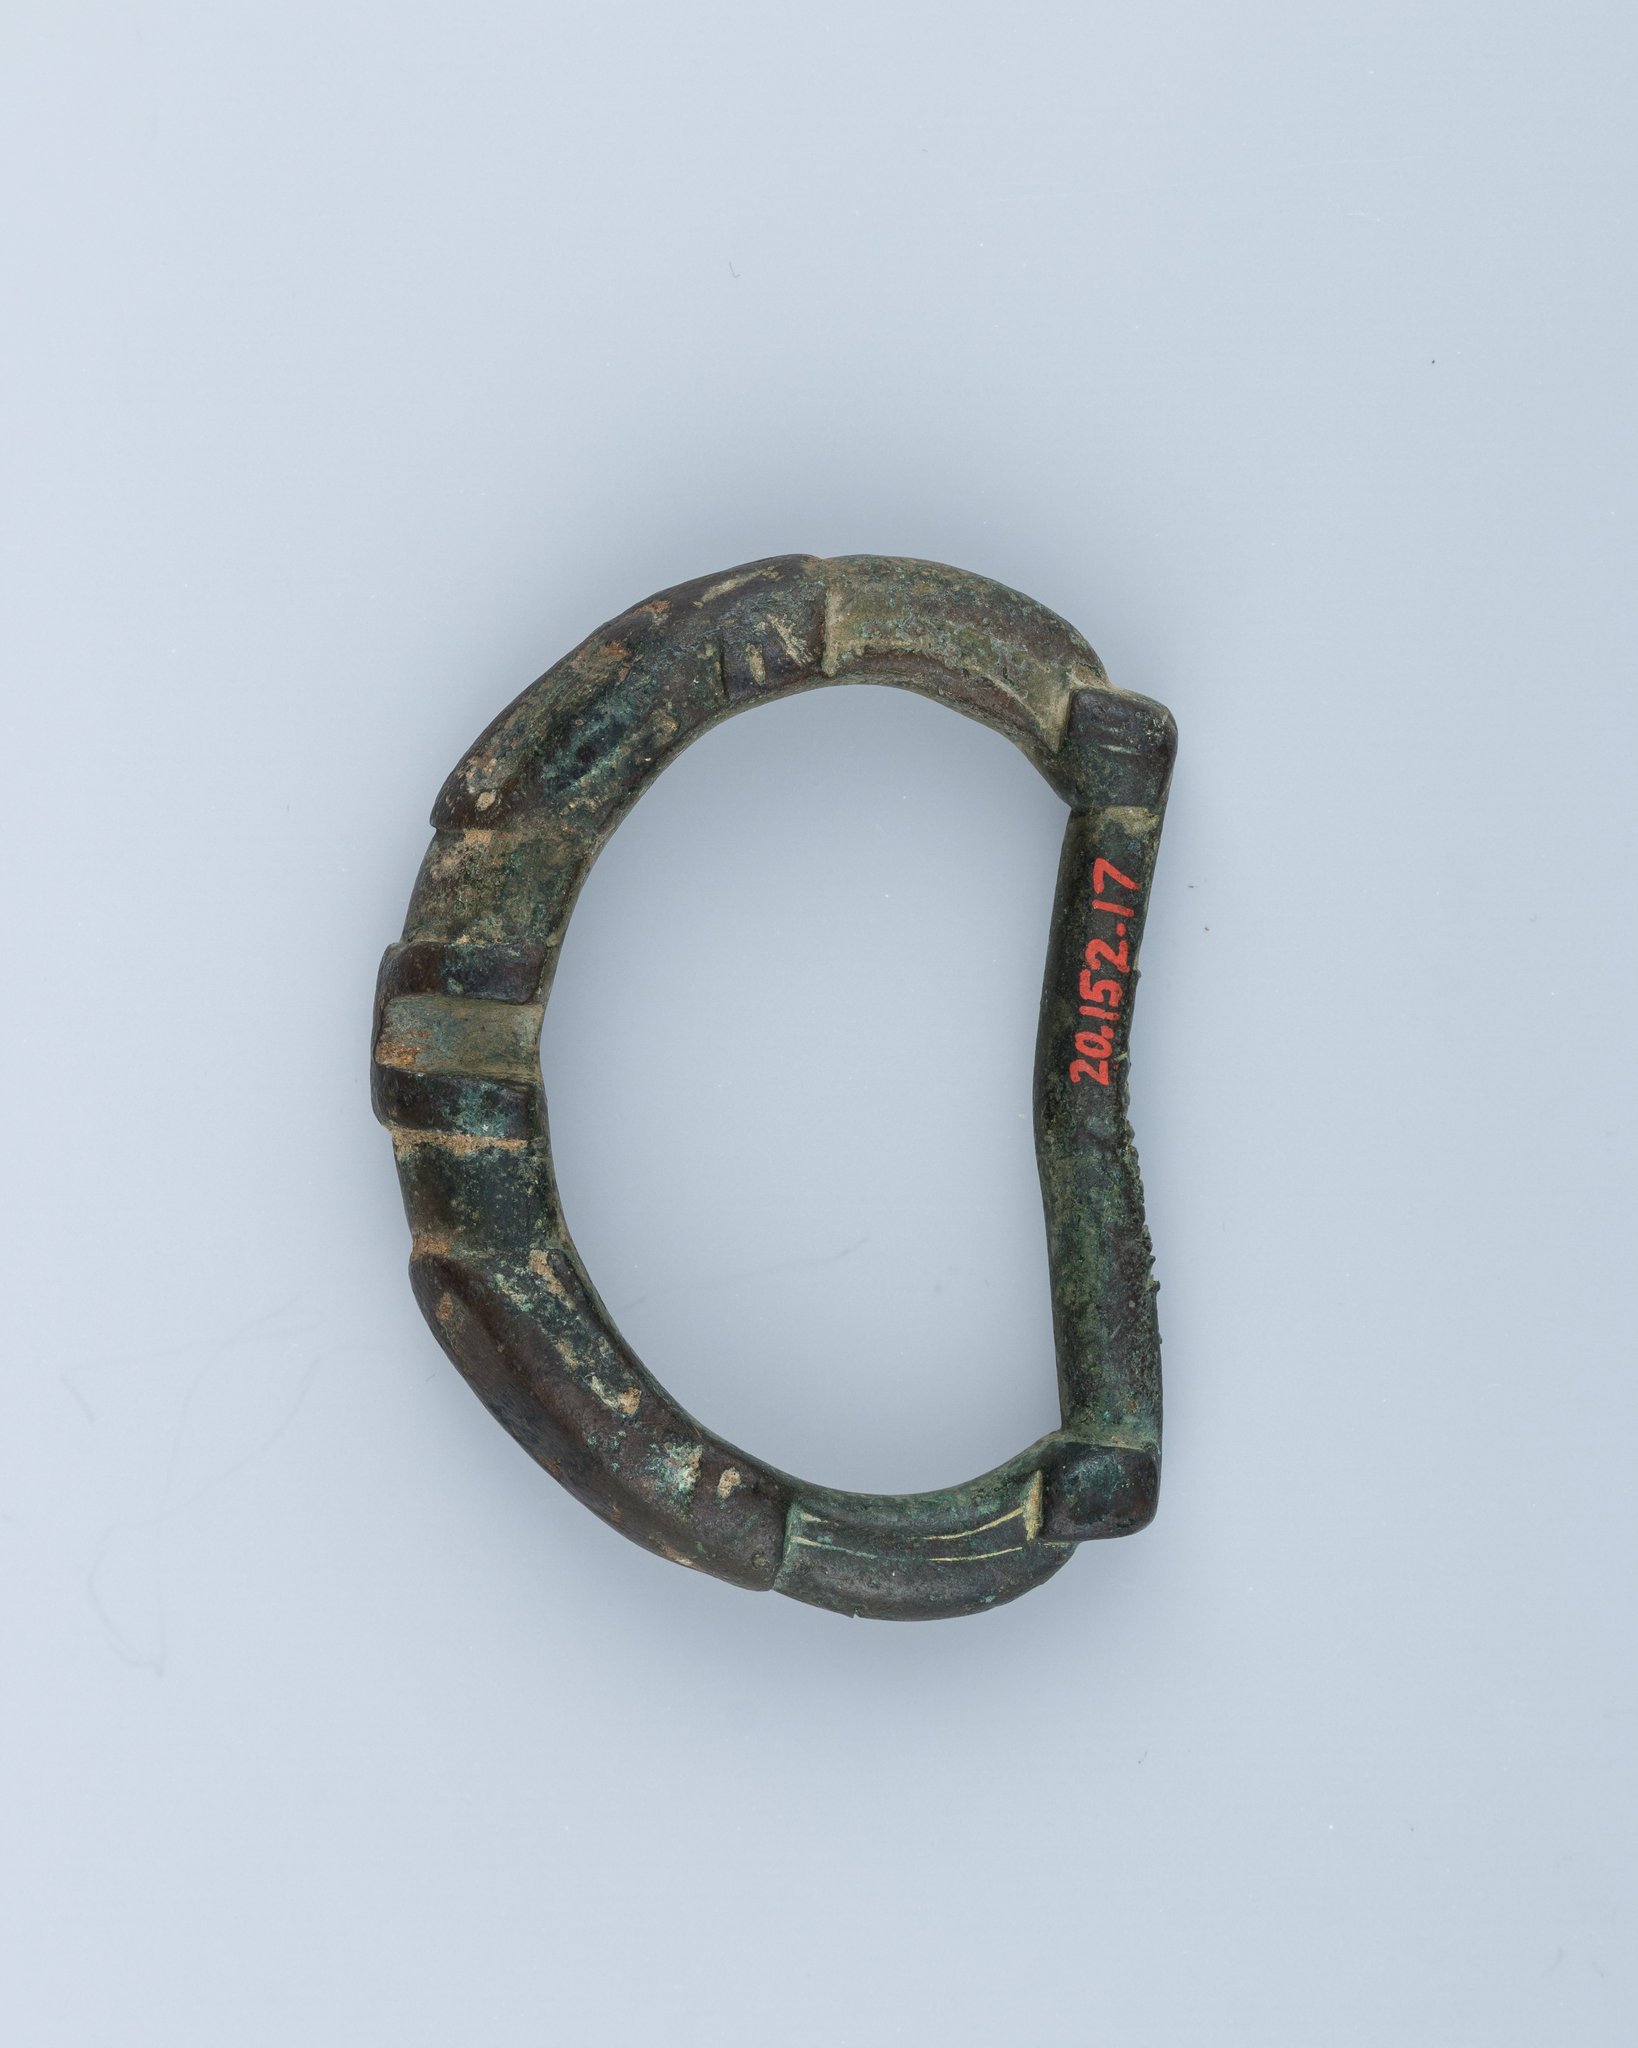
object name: buckle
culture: ibero-roman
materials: bronze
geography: spain or portugal